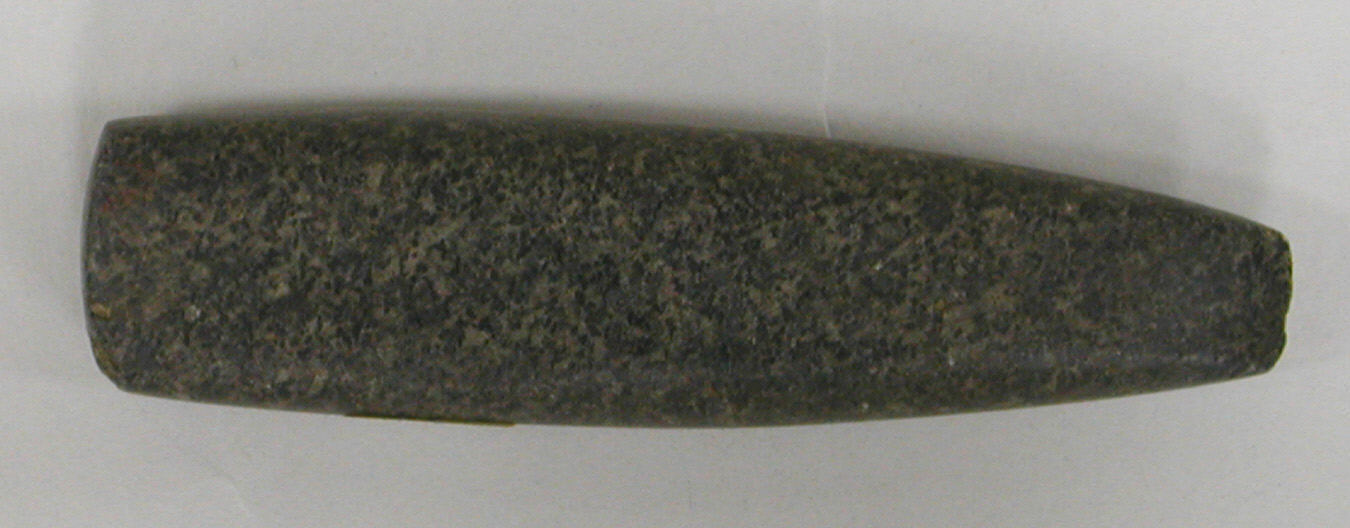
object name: chisel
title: Stone Chisel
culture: mexican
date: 1501-1600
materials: stone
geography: mexico